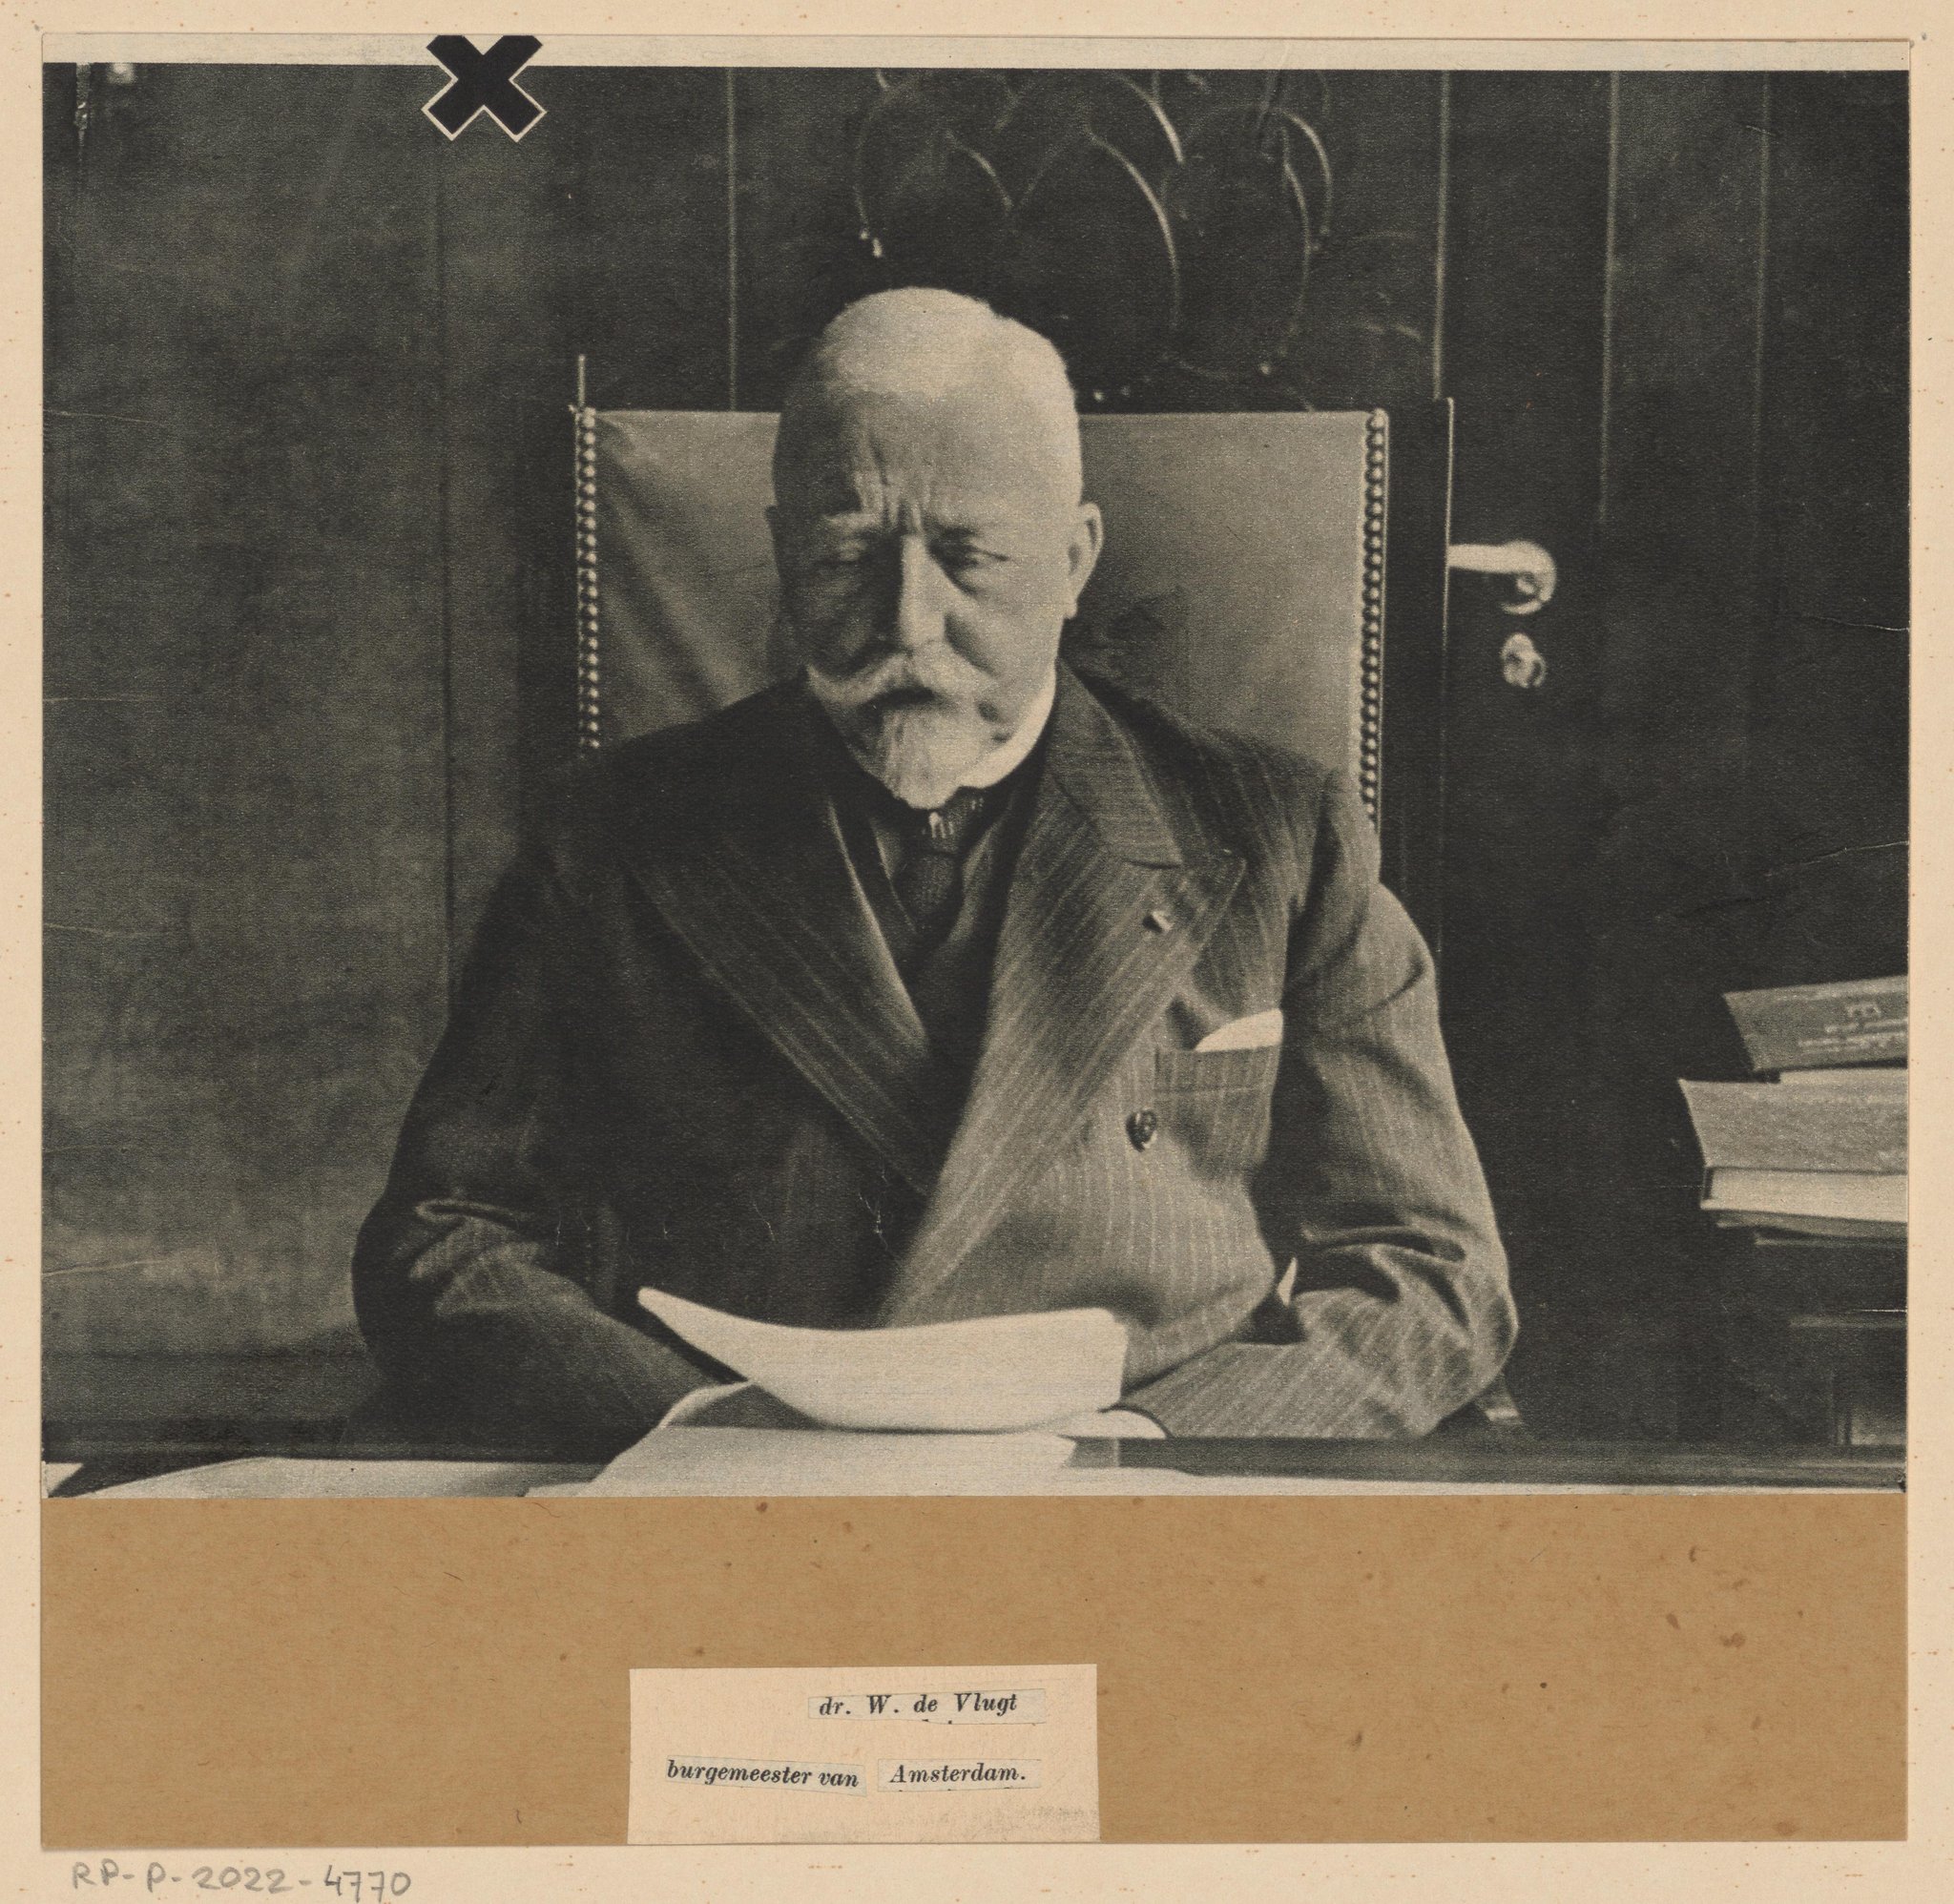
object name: photomechanical print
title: Portret van Willem de Vlugt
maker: Anonymous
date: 1935-1941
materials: paper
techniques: rotogravure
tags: amsterdam, politician, official; civil servant; functionary (in general), historical persons, politician, e.g. party leader